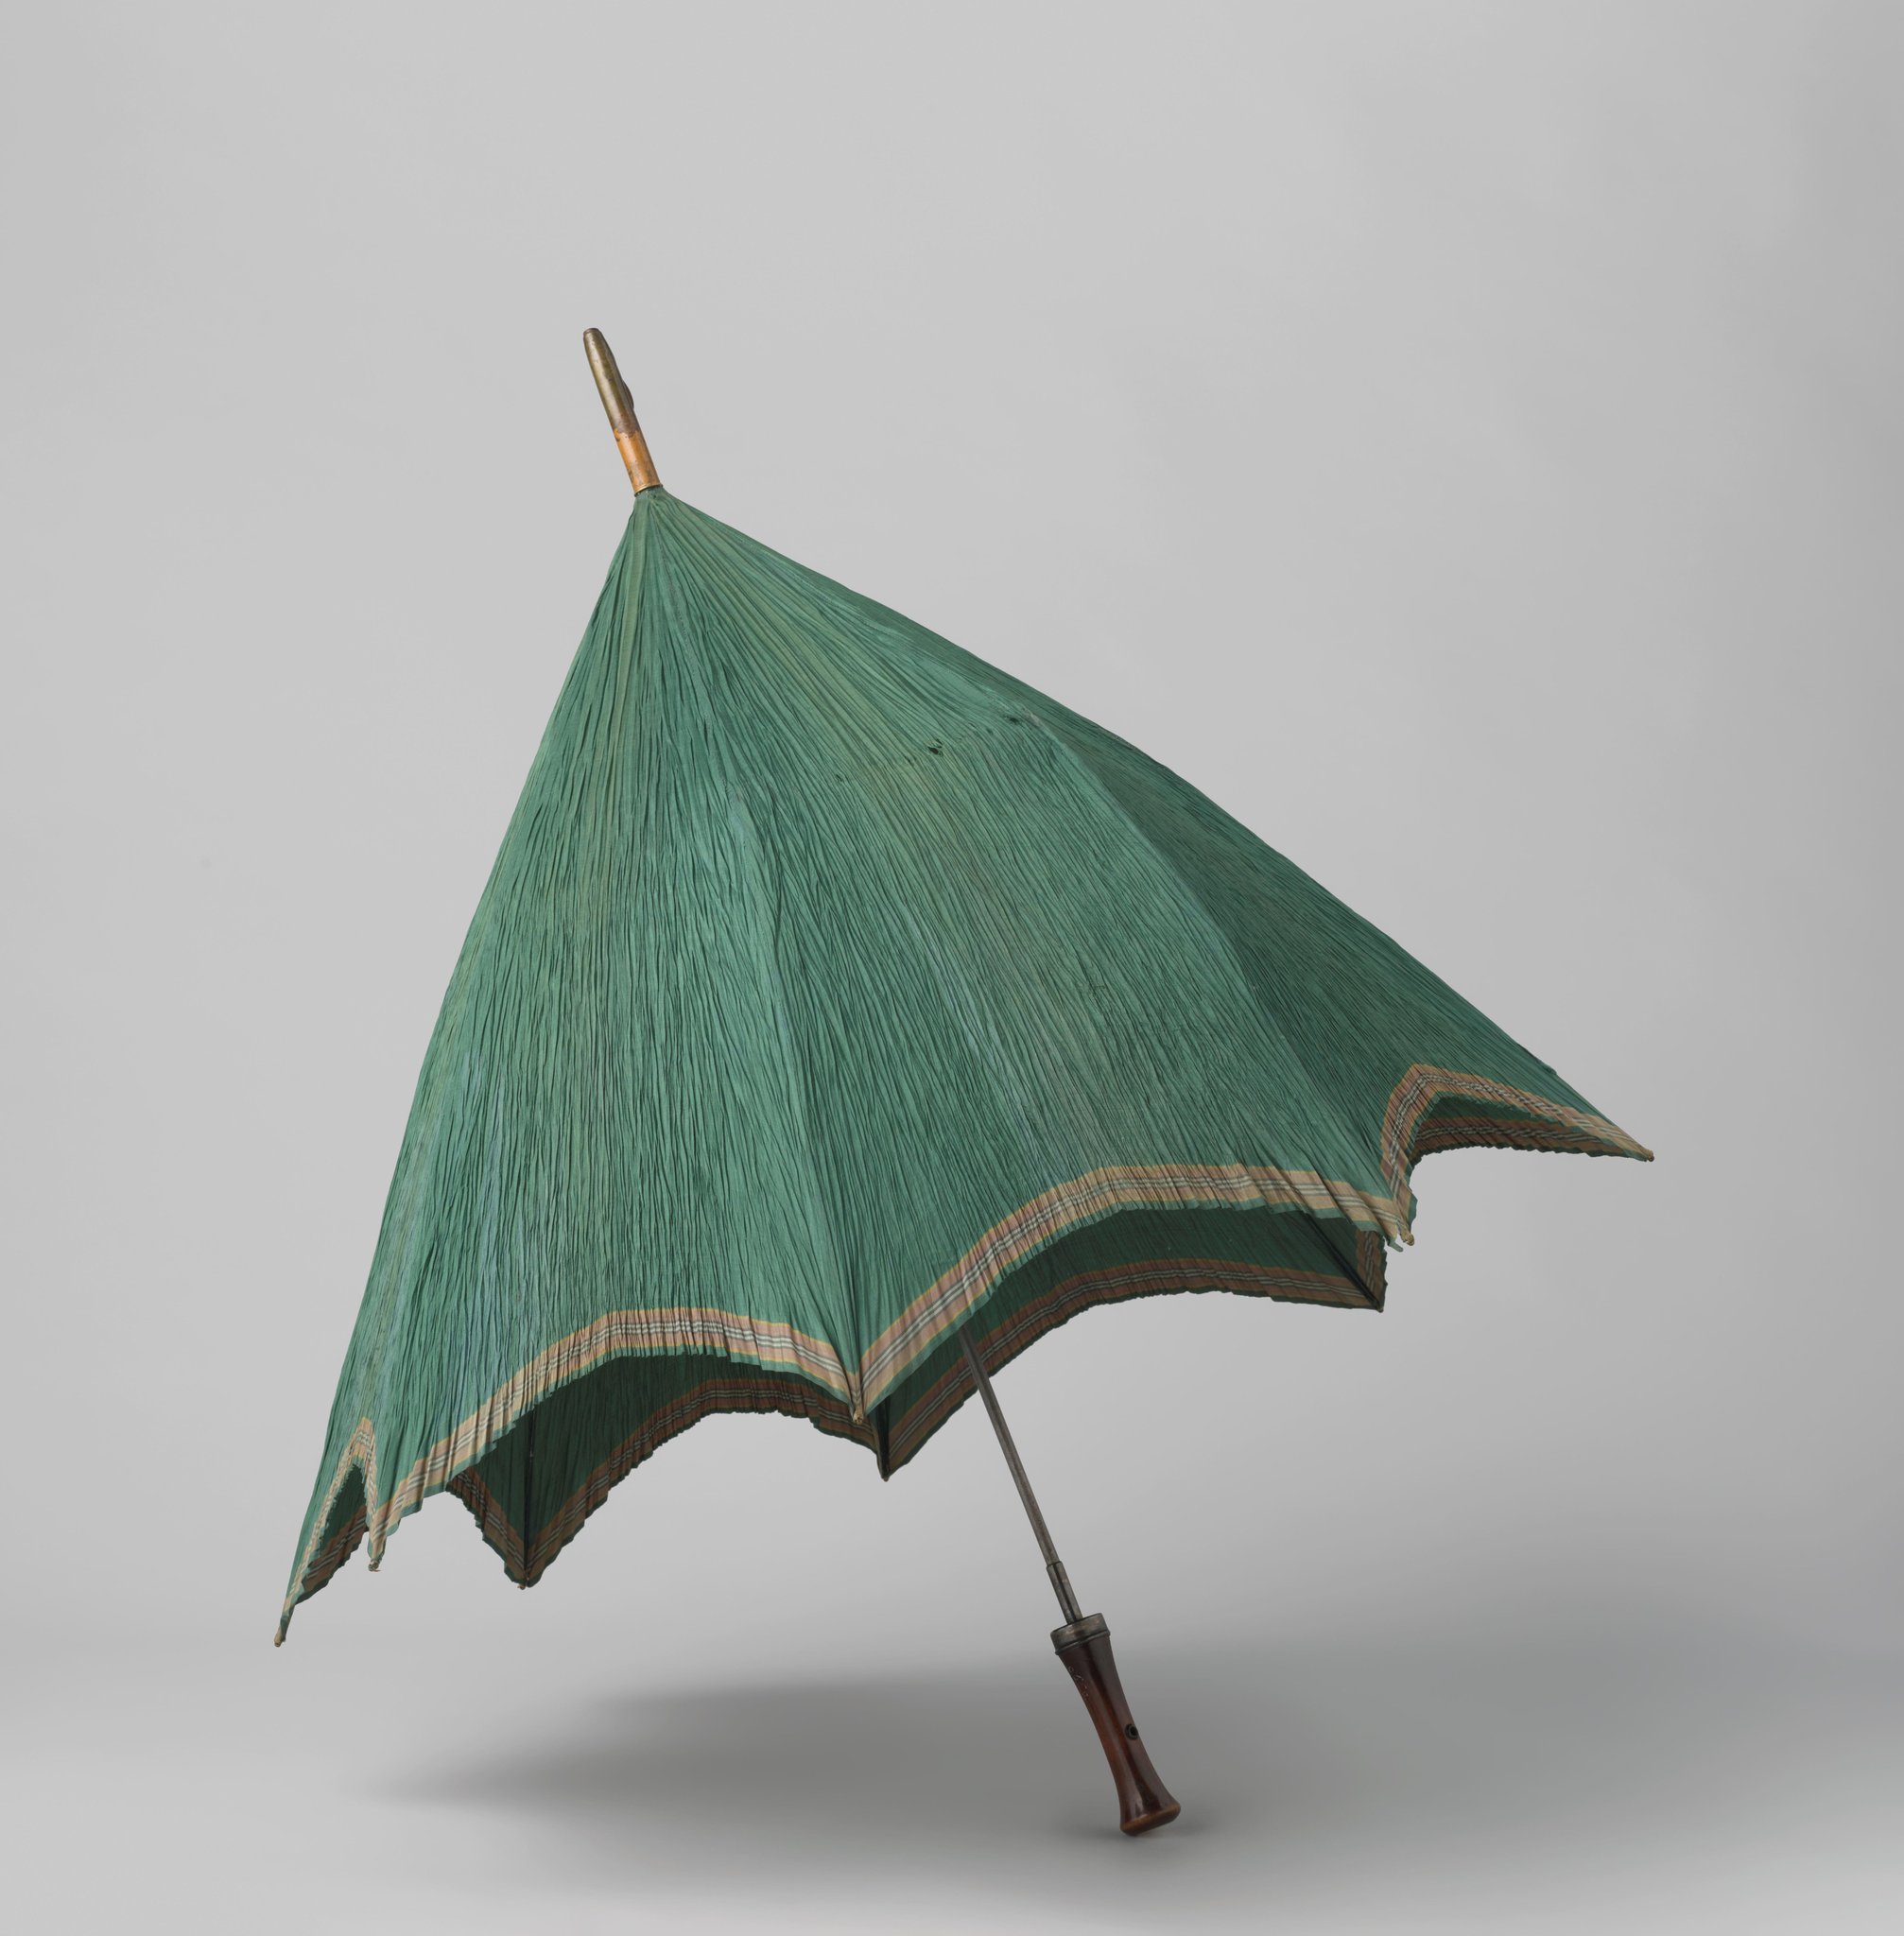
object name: walking stick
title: Parasol met dek van groene zijde met ingeweven streep langs de rand, op een ijzeren stok waaraan een houten handgreep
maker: Anonymous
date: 1825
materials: iron, mother of pearl, silk, wood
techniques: cutting, forging, weave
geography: netherlands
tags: cornelis rudolphus theodorus krayenhoff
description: Parasol met dek van dunne groene gepliseerde zijde met ingeweven streep langs de rand. Ongevoerd, op acht ijzeren baleinen op een ijzeren stok. Het handvat is van hout, met onderop een cirkel van ingelegde witte parelmoer. Bovenop een geverfde koperen knop, met halverwege een veer.